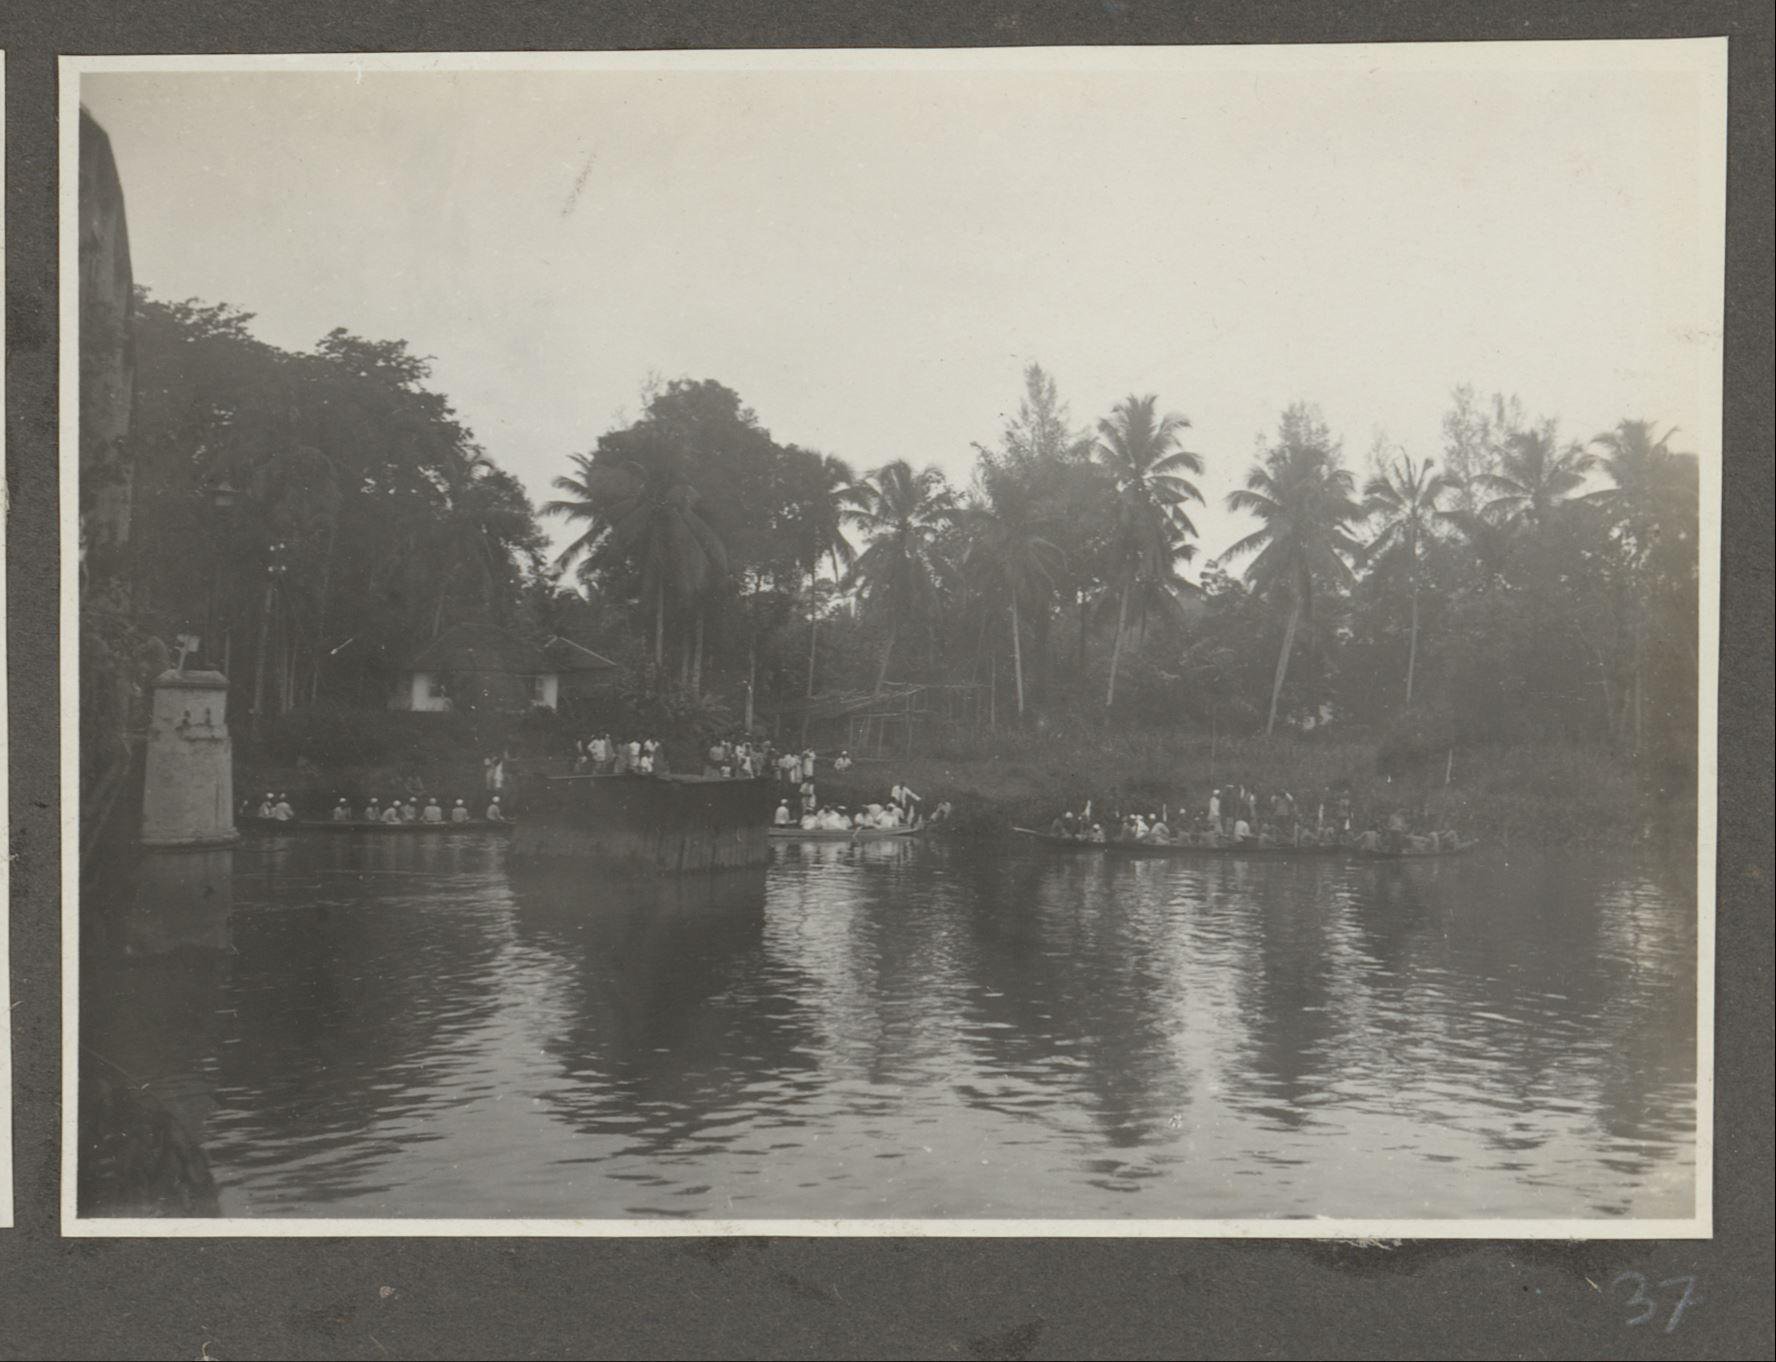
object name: photograph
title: Boten op de Wampoerivier bij het jubileum van de Sultan van Langkat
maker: Anonymous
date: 1919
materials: photographic support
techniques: gelatin silver print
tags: river, historical persons, rowing, canoeing, etc. (sport)